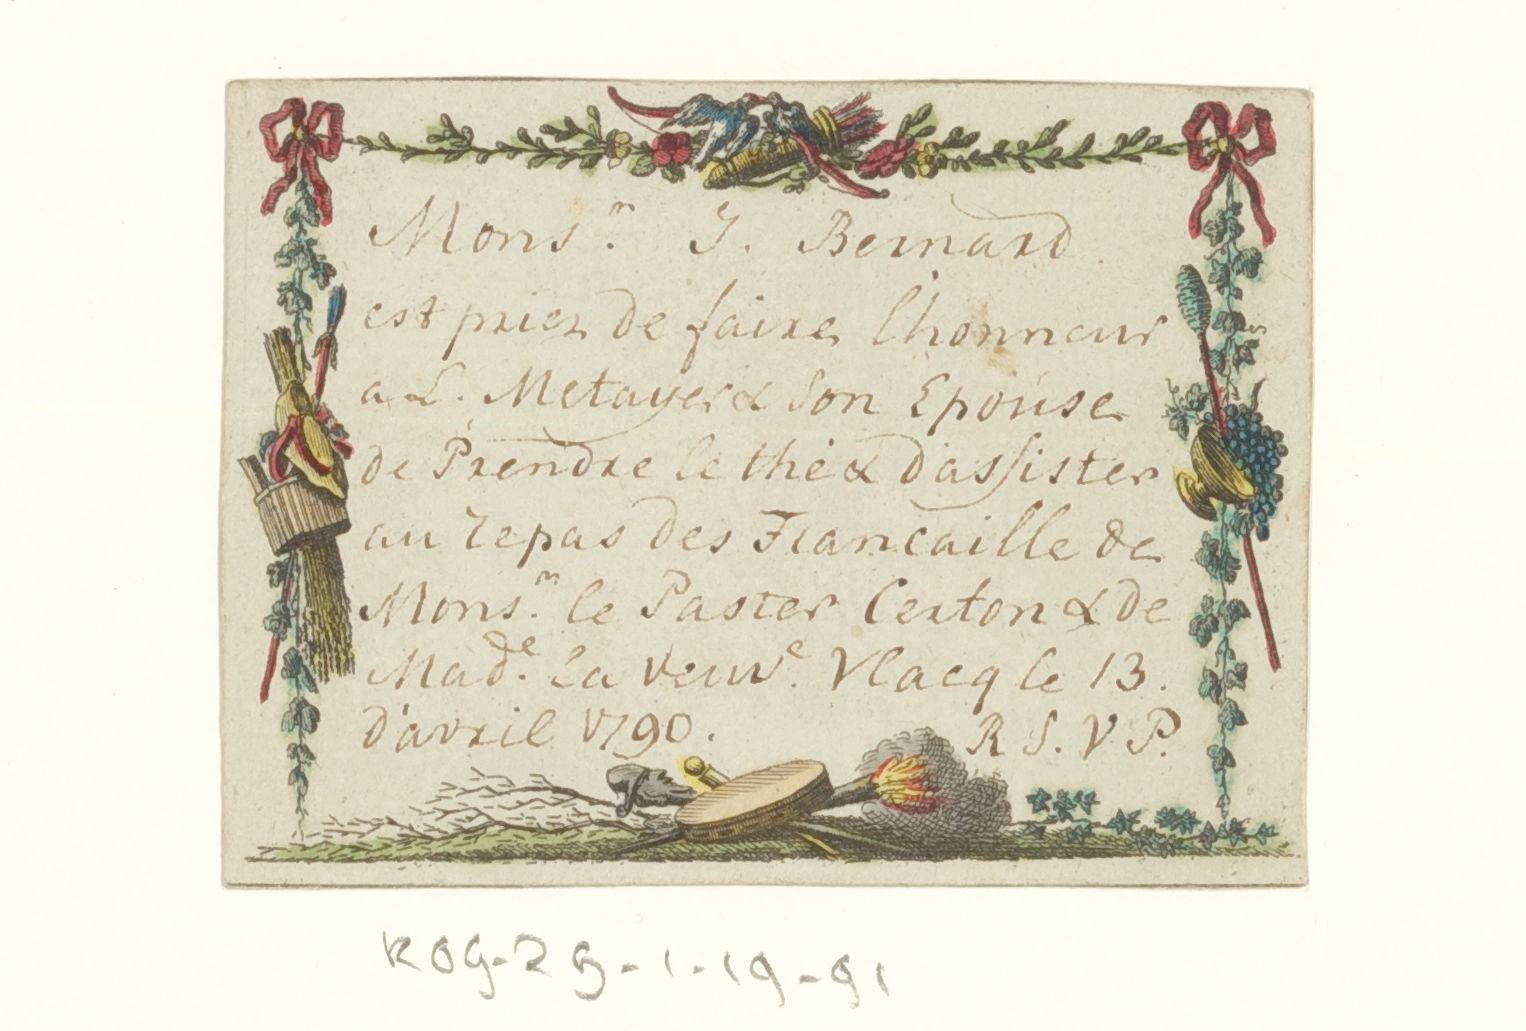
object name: print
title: Uitnodiging aan dhr. J. Bernard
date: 1704-1790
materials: paper, watercolor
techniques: etching, hand coloring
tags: print maker, draughtsman, jean bernard, louis metayer phzn., rotterdam, catharina elisabeth metayer, antoinette bernard, letter, envelope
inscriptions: collector's mark, collector's mark: Lugt 1641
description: Kaartje met een handgeschreven uitnodiging en RSVP aan dhr. J. Bernard namens L. Metayer en zijn vrouw voor het verlovingsdiner van de predikant Henri Abraham Certon en Mad.e la Veuve Vlacq (Catharina Elisabeth Metayer) op 13 april 1790. Onderdeel van een groep van bruilofts- en invitatiekaartjes van de families Bernard en Metayer. Onderwerpsrubrieken binnen de Atlas Zeden en Gewoonten: Des Menschen Begin, Midden en Einde. Bruiloft en huwelijk.